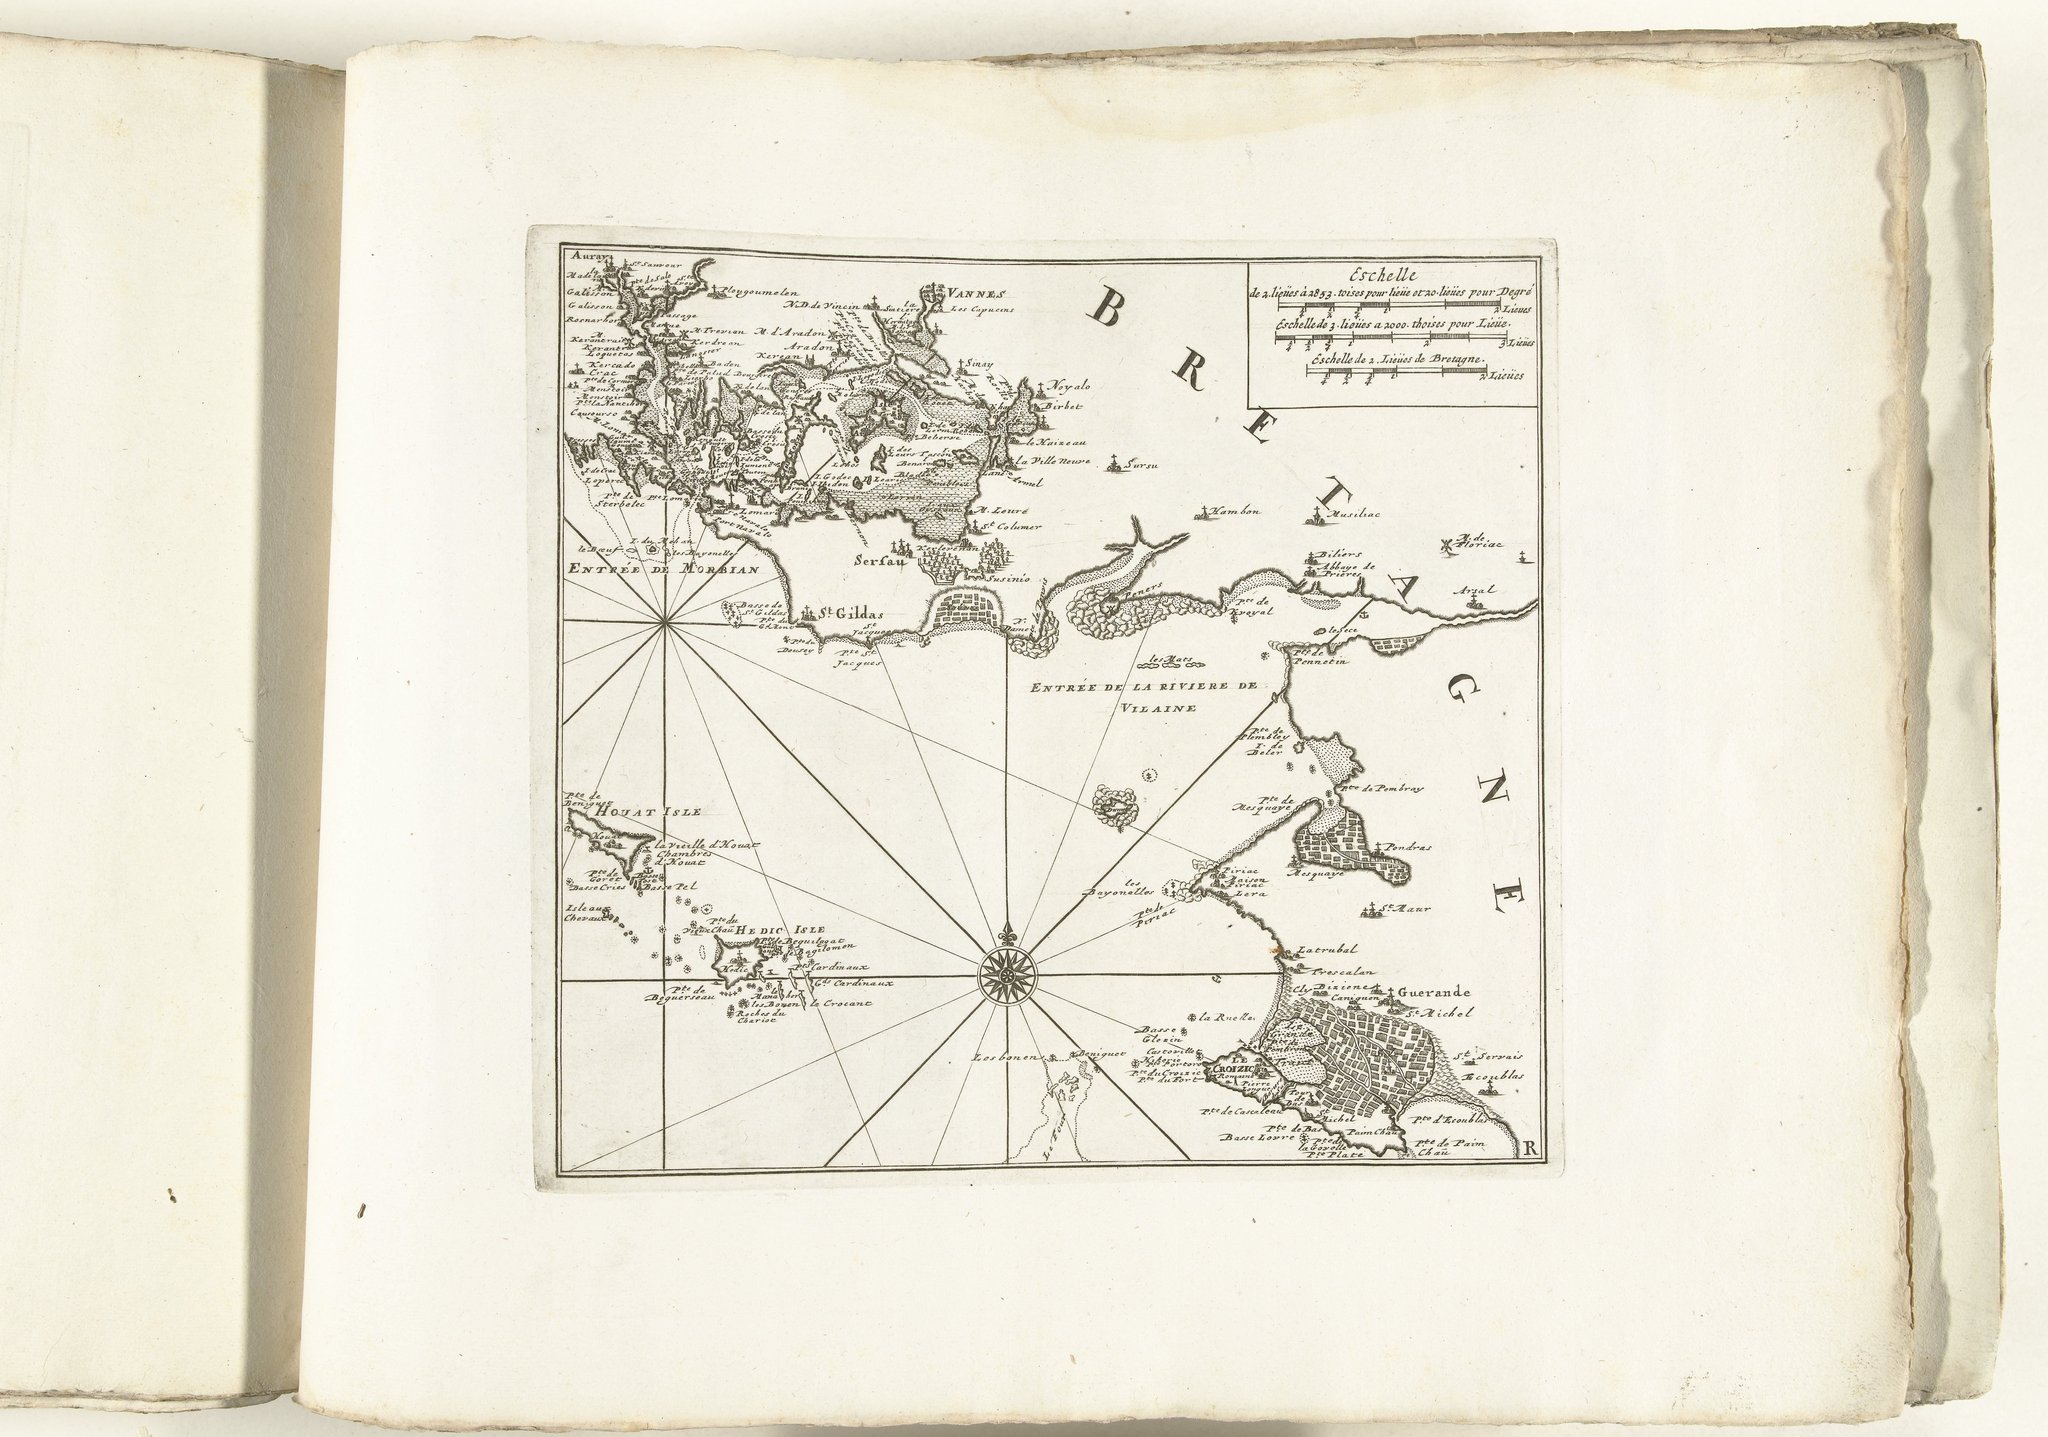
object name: map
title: Kaart van de zuidkust van Bretagne bij Vannes, ca. 1702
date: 1702-1703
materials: paper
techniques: engraving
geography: amsterdam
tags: maps of separate countries or regions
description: Kaart van de zuidkust van Bretagne bij Vannes. Gemerkt rechtsonder: R. Onderdeel van het eerste van twee delen van het prentwerk: Les costes de France et d'Espagne (oftewel deel 13 van: Les Forces de l'Europe, Asie, Afrique et Amerique), uitgegeven ca. 1702. Het prentwerk bestaat in totaal uit 43 gemerkte platen van de kust van Frankrijk en Spanje, in het kader van de Spaanse Successieoorlog. Deze platen zijn gekopieerd naar anonieme Franse platen oorspronkelijk uitgegeven door Nicolas de Fer te Parijs. Titel en opschriften in de plaat in het Frans.